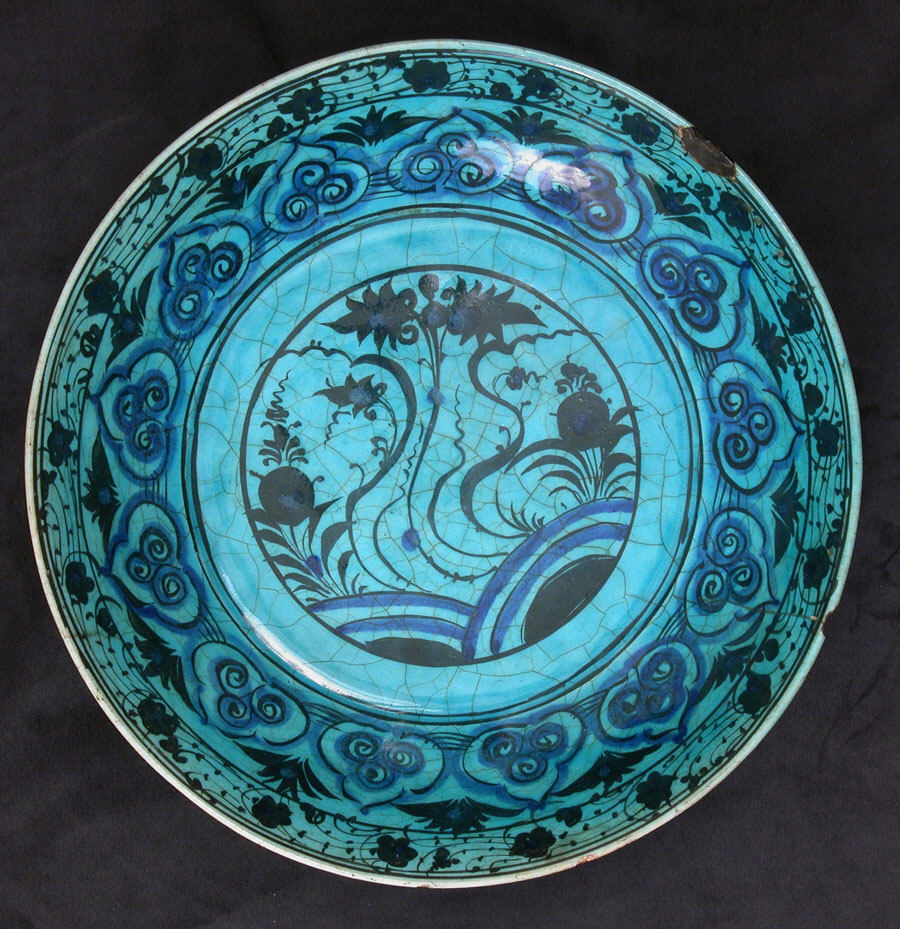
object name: dish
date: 1501-1700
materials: glaze, stonepaste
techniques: painting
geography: iran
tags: plants